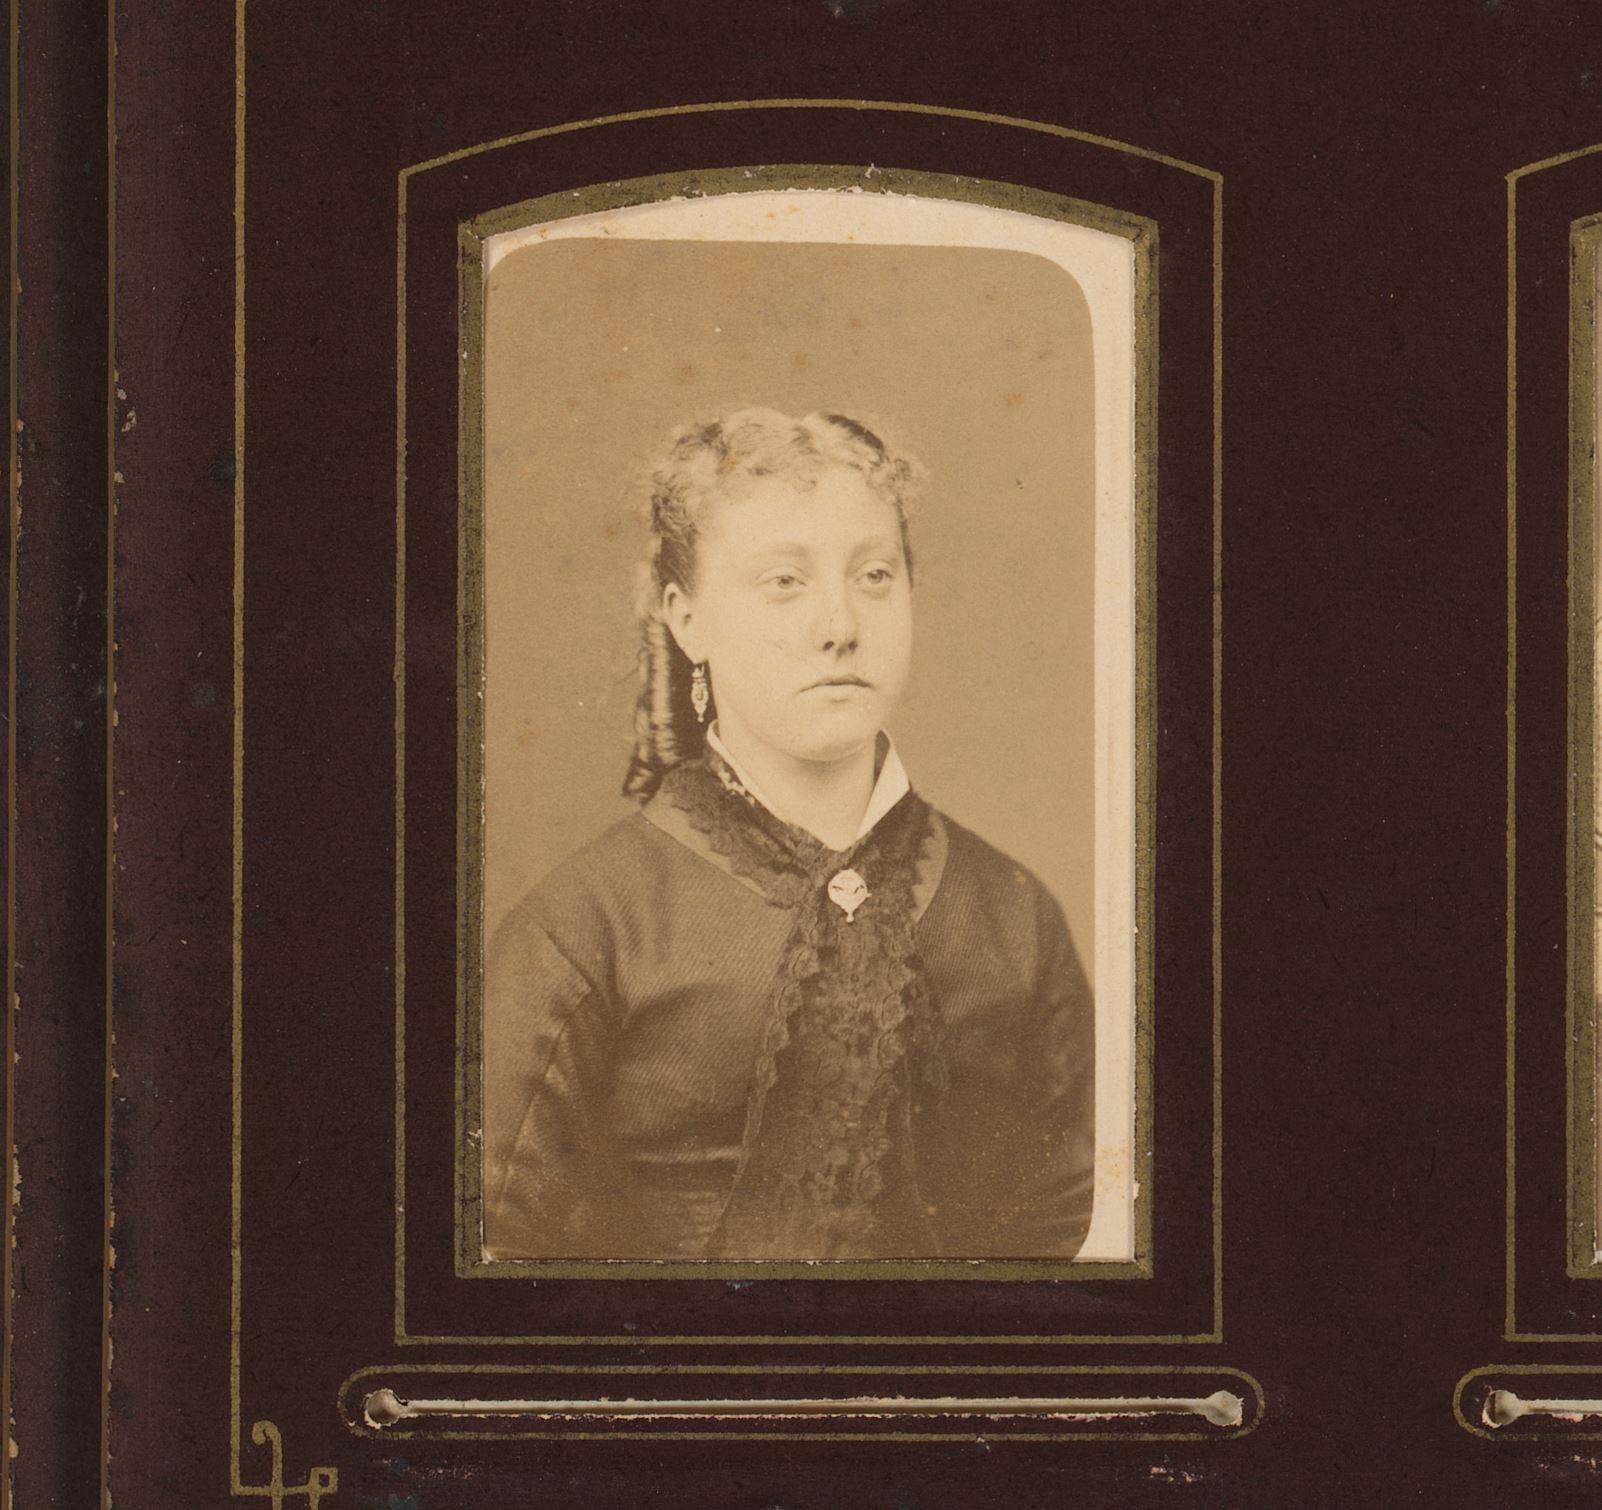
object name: album leaf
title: Portret van een vrouw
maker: Anonymous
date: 1850-1900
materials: cardboard, photographic support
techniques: albumen print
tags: historical persons - bb - woman